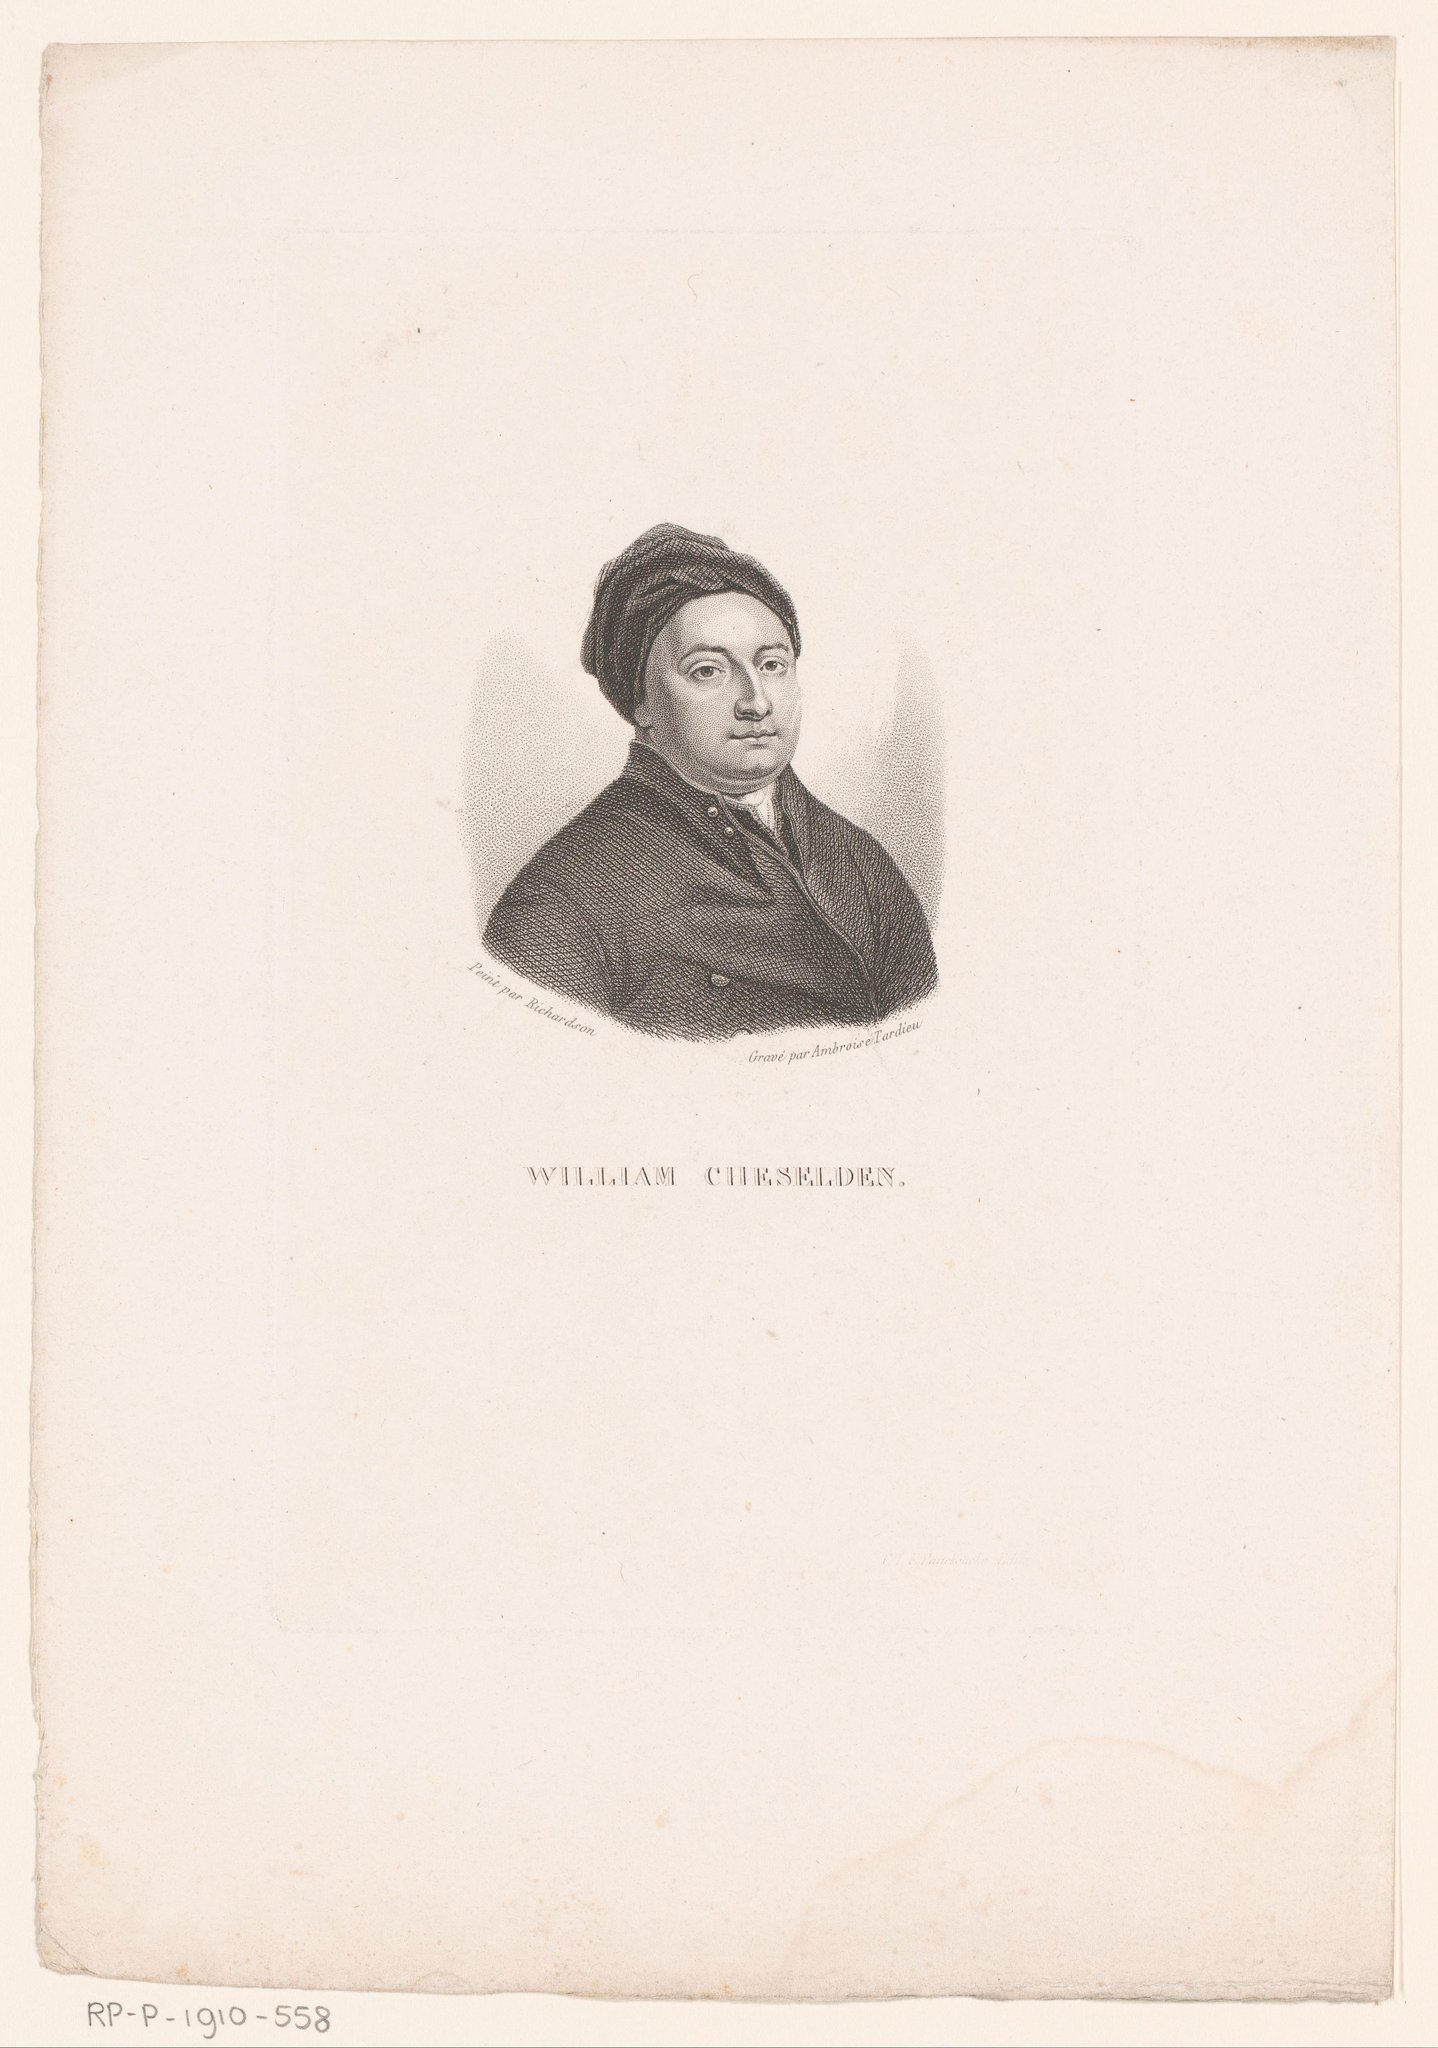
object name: print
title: Portret van William Cheselden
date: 1798-1841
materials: paper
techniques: engraving, roulette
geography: paris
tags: historical persons, physician, doctor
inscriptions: collector's mark: Lugt 2228